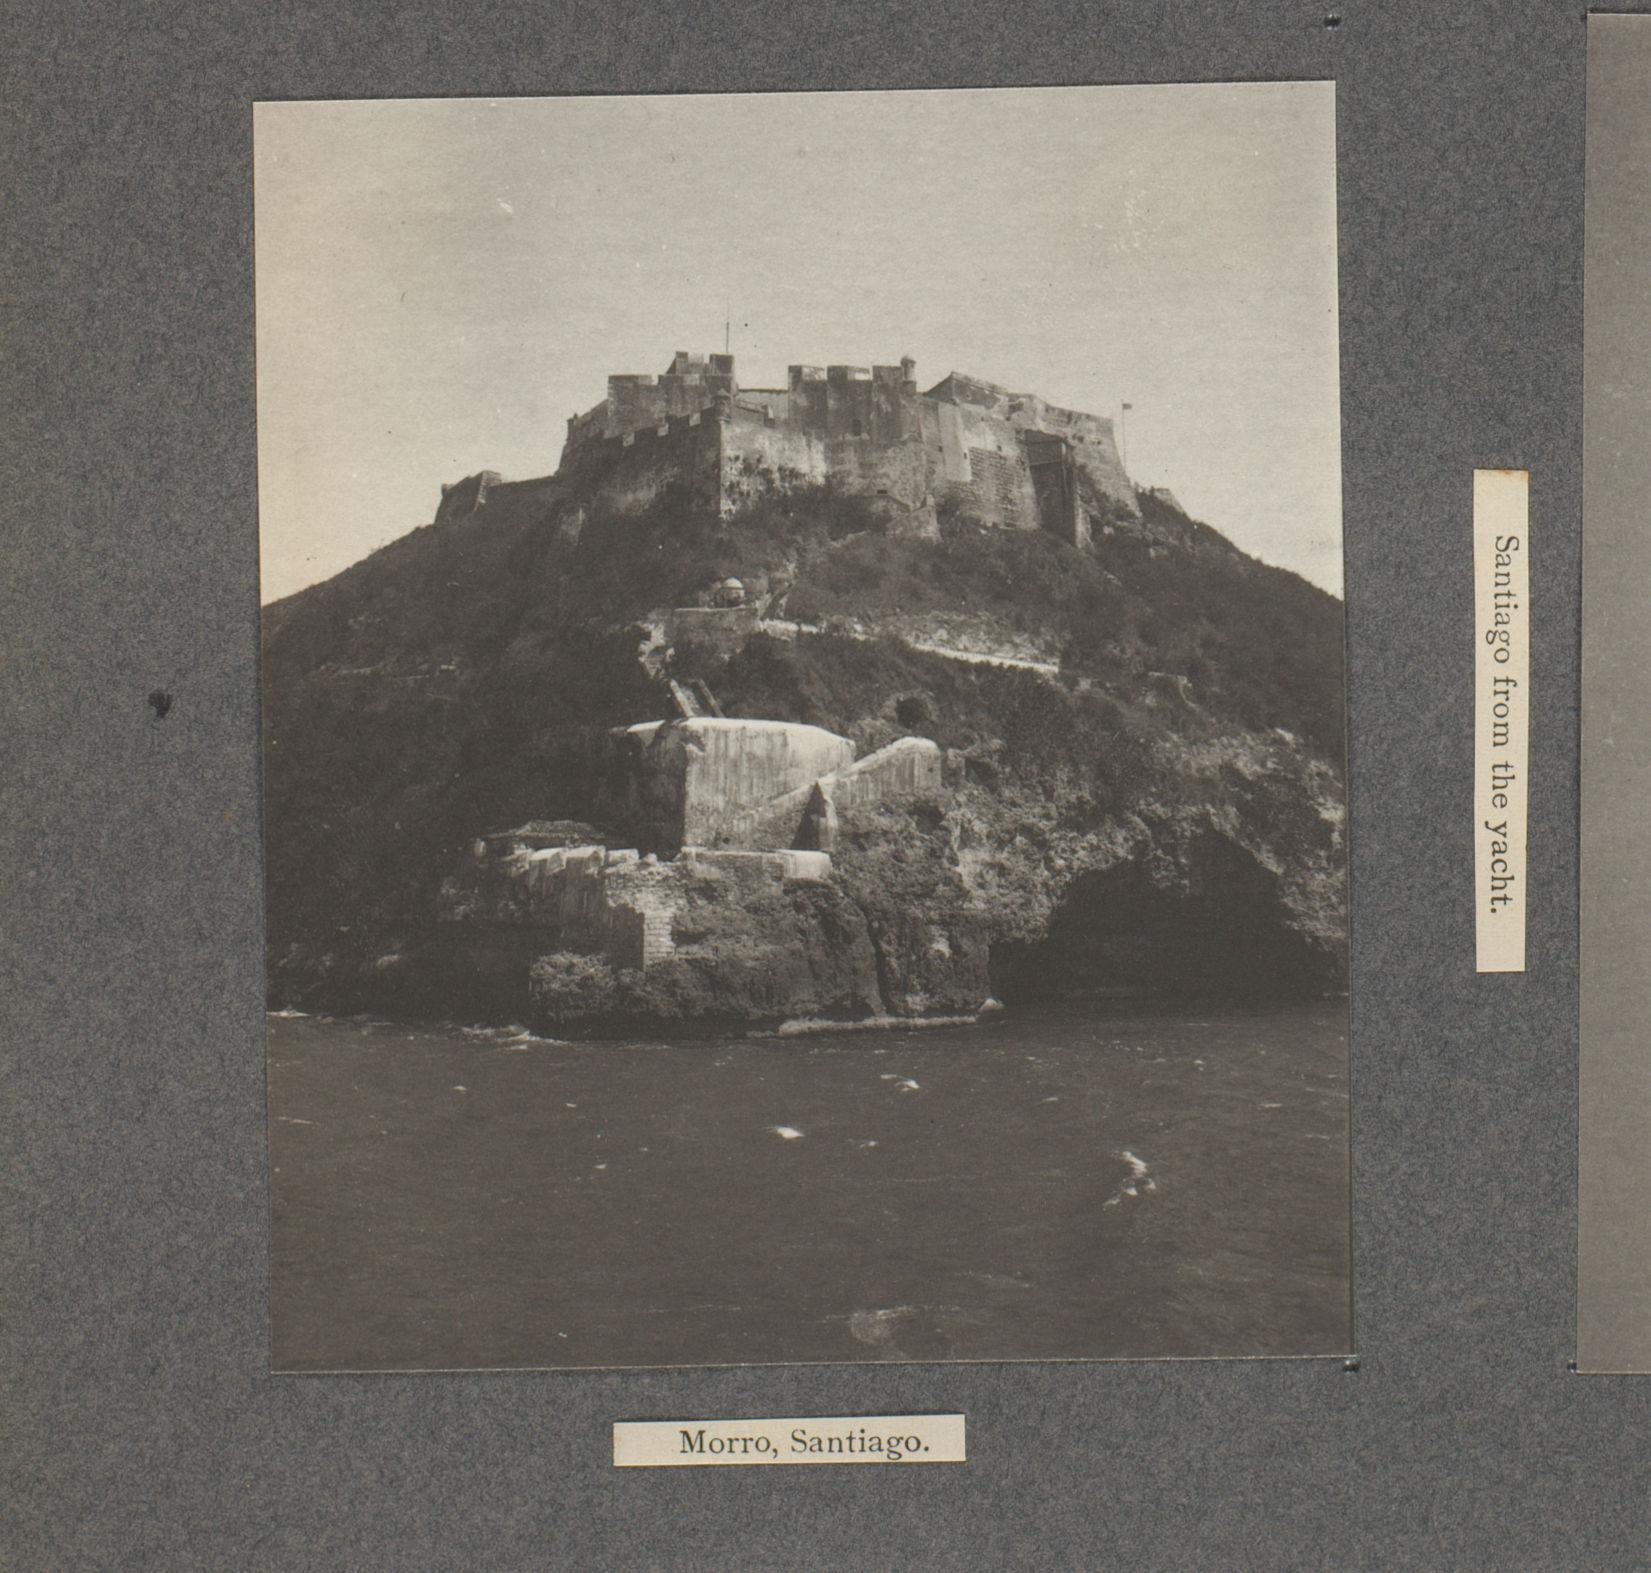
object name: album leaf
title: Gezicht op Castillo del Morro in Santiago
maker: Anonymous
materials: paper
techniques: platinum process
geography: santiago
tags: fortifications, military engineering